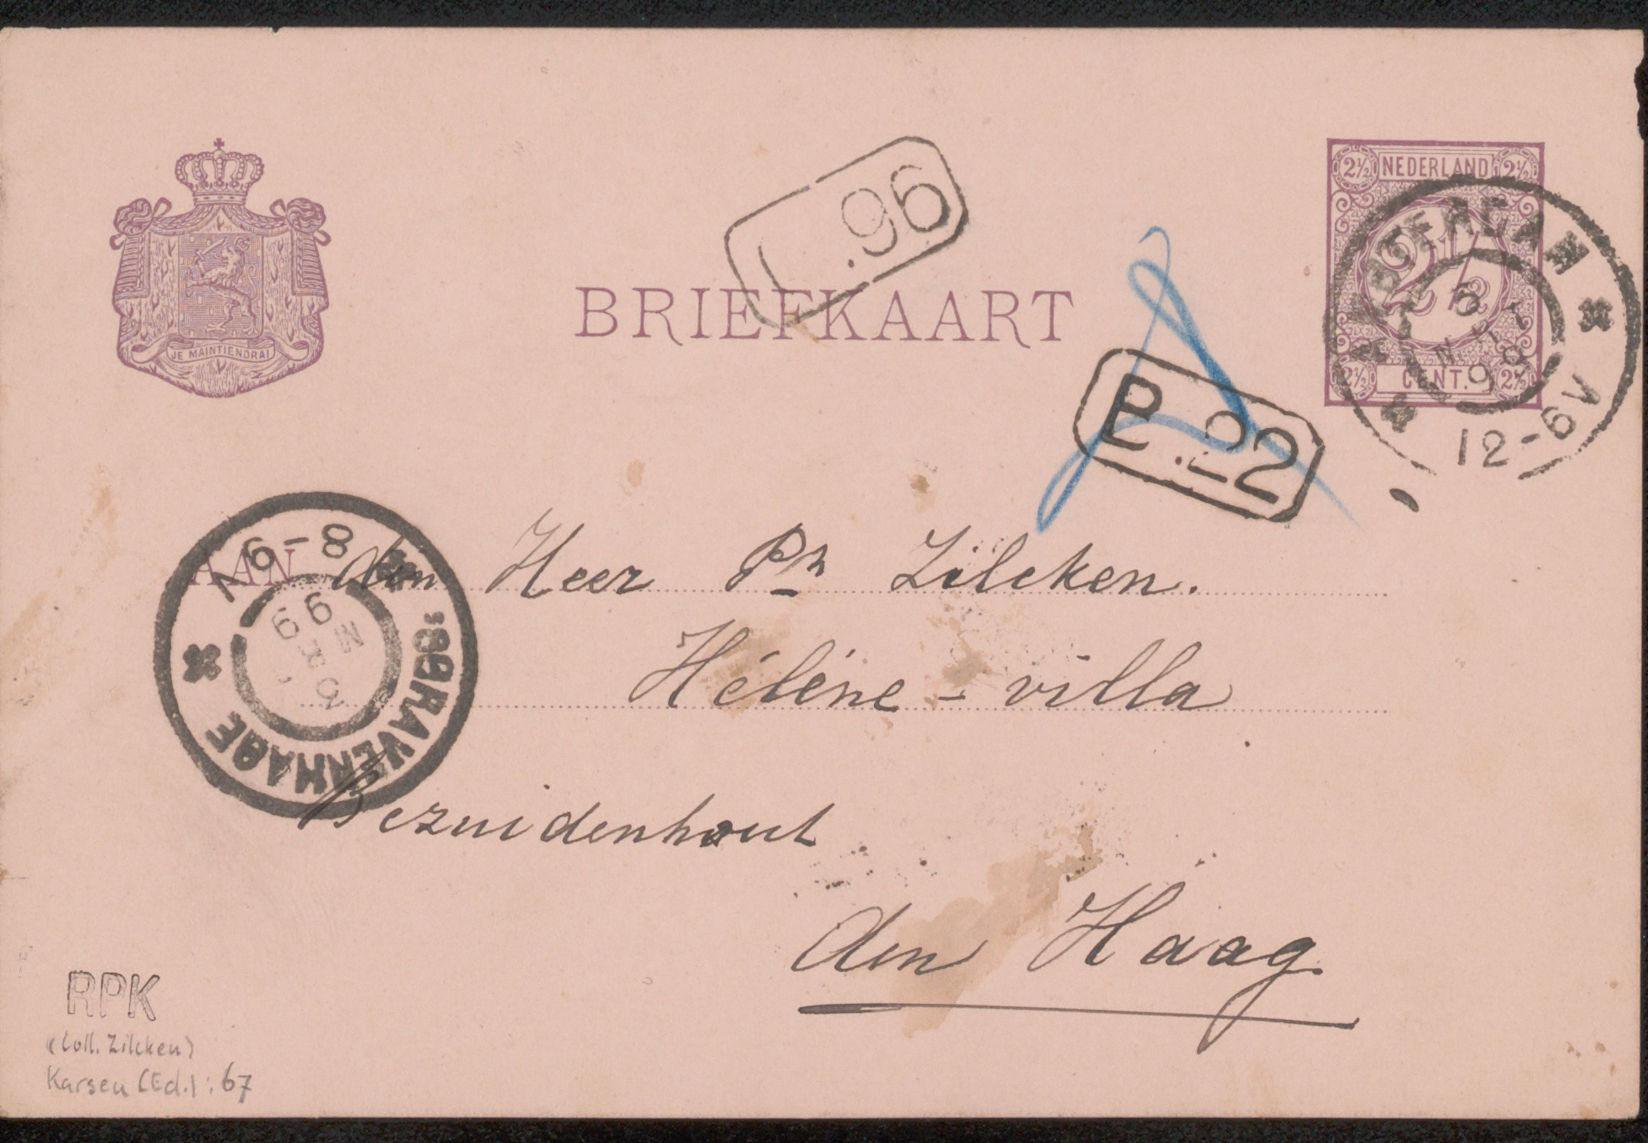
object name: postcard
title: Briefkaart aan Philip Zilcken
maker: eduard karsen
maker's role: draughtsman, painter, print maker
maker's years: 1860-1941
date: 1899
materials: cardboard, ink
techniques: pen, writing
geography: amsterdam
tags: h.l. berckenhoff, dordrecht, cornelis gerardus 't hooft, the hague, philip zilcken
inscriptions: collector's mark: ‘RPK’